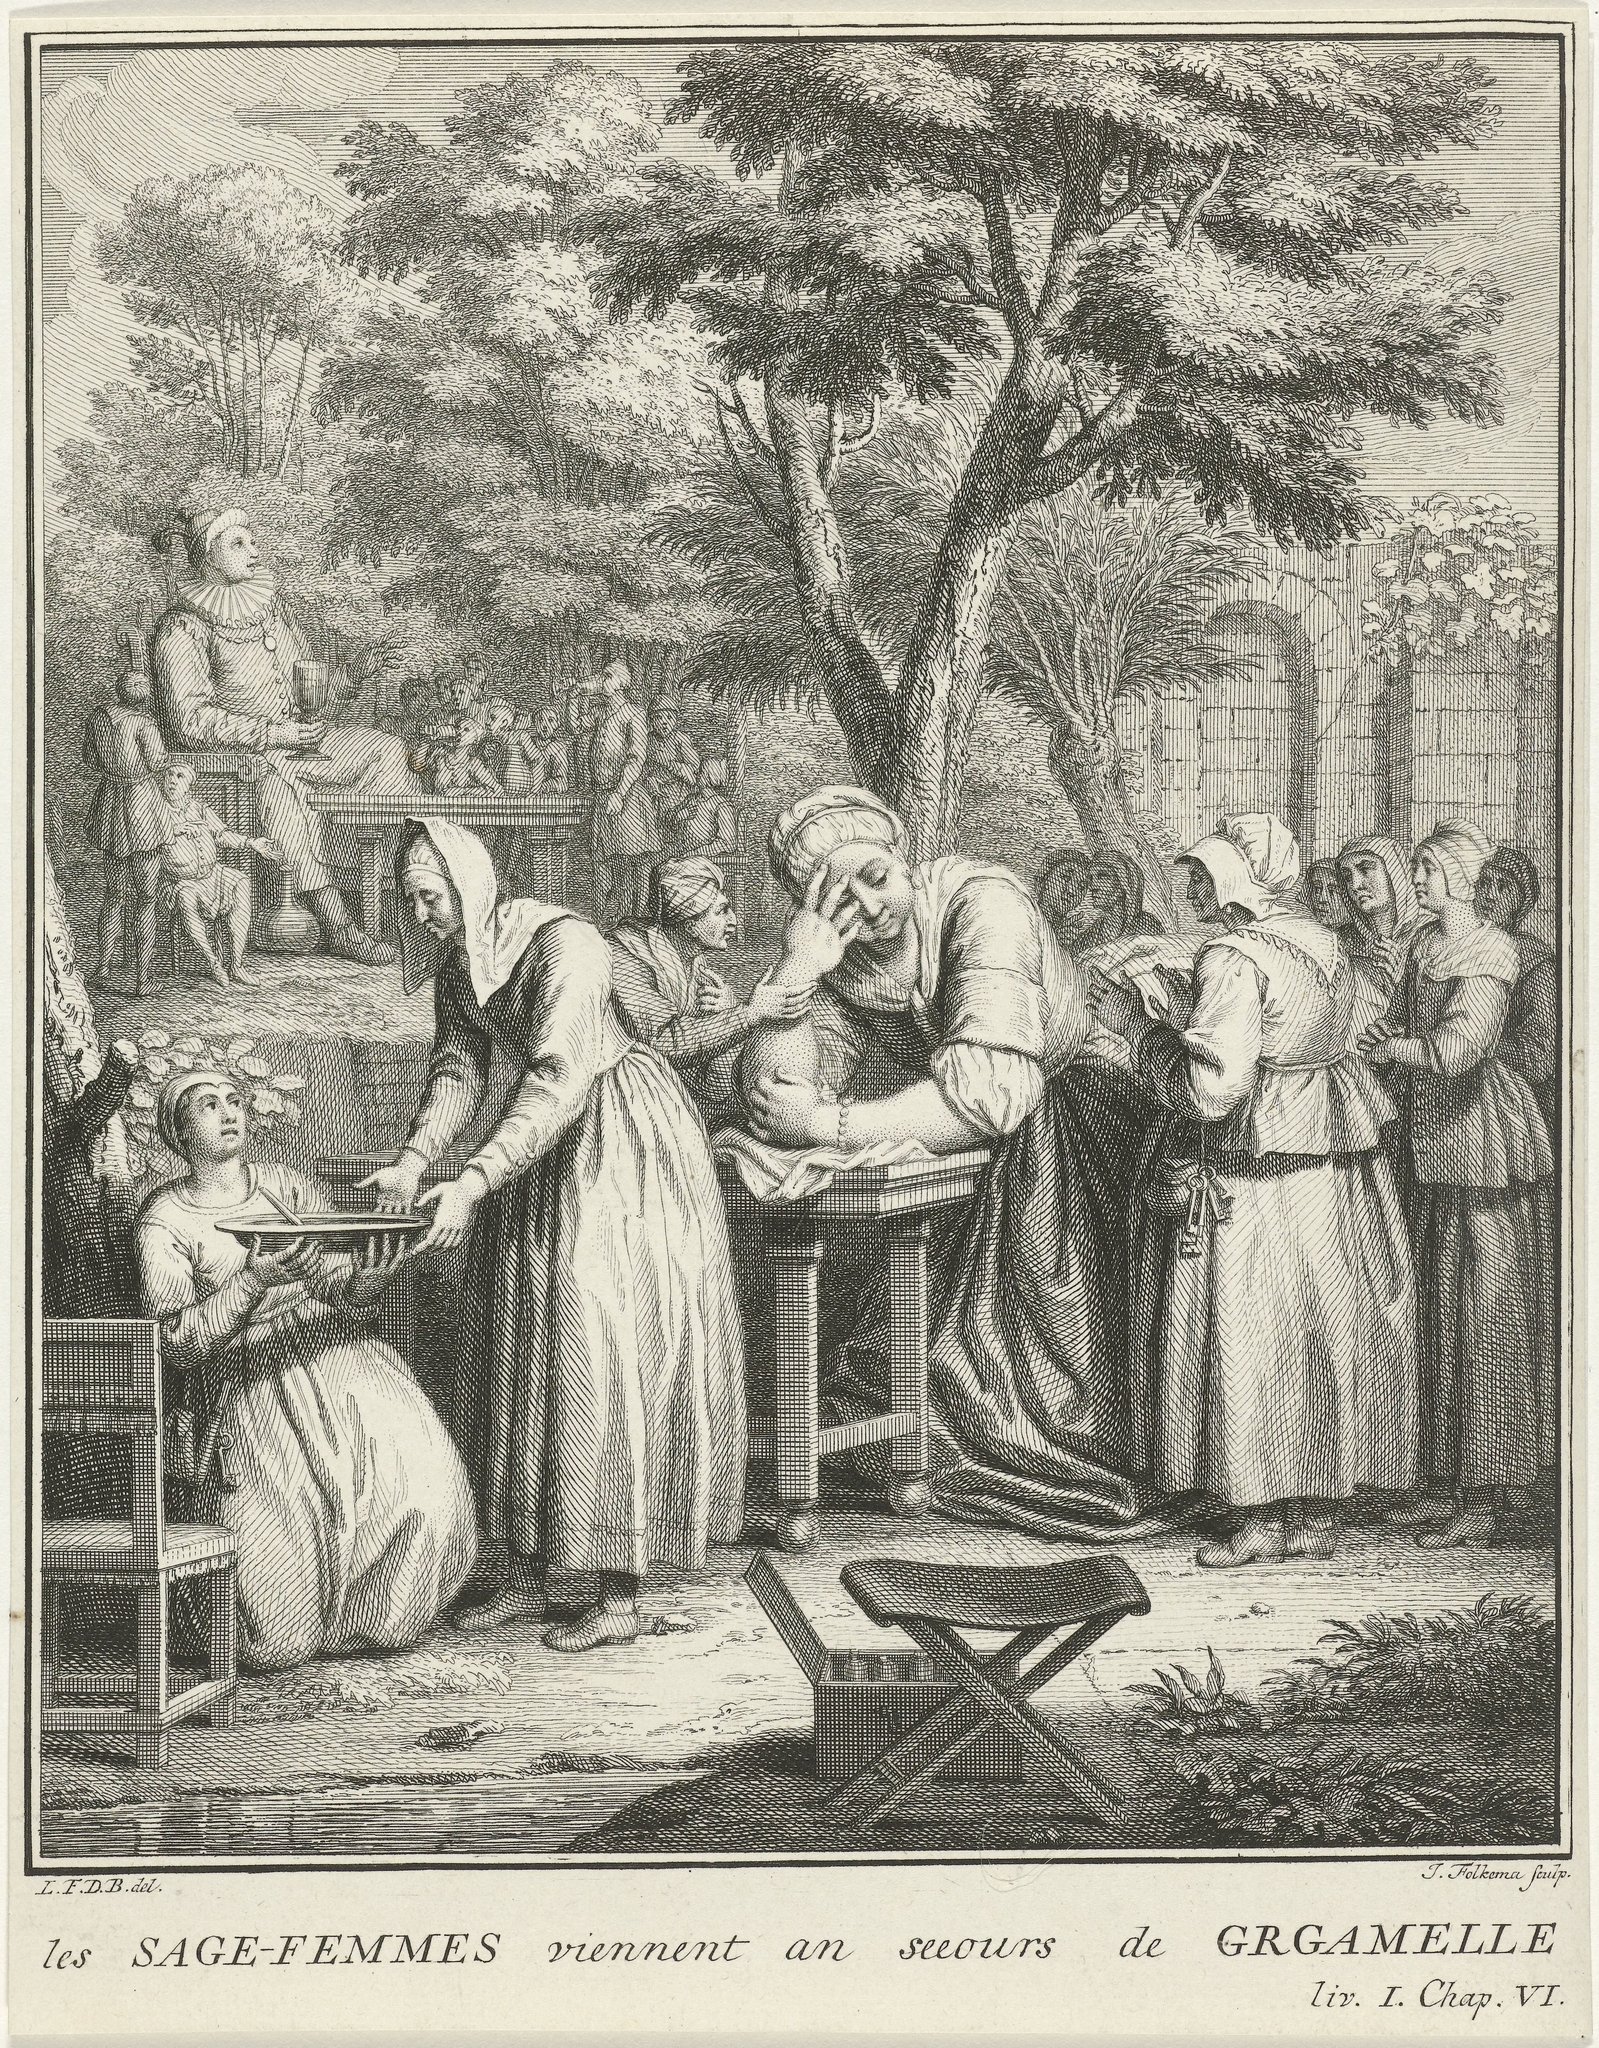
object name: print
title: Avonturen van Gargantua and Pantagruel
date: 1703-1767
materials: paper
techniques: etching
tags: giants, colossi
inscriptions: collector's mark: Lugt 240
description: De reuzin Gargamella is al elf maanden zwanger als ze tijdens een groot drink- en eetfestijn moet bevallen. Haar zoon Gargantua wordt uit haar linkeroor geboren in plaats van uit haar schoot, omdat ze te veel ingewanden heeft gegeten. Een groep vrouwen schiet Gargamella te hulp, op de achtergrond verteld haar man Grandgosier toehoorders een verhaal. In de marge staat een regel tekst in het Frans, rechtsonder gemerkt: Liv.1. Chap. VI.